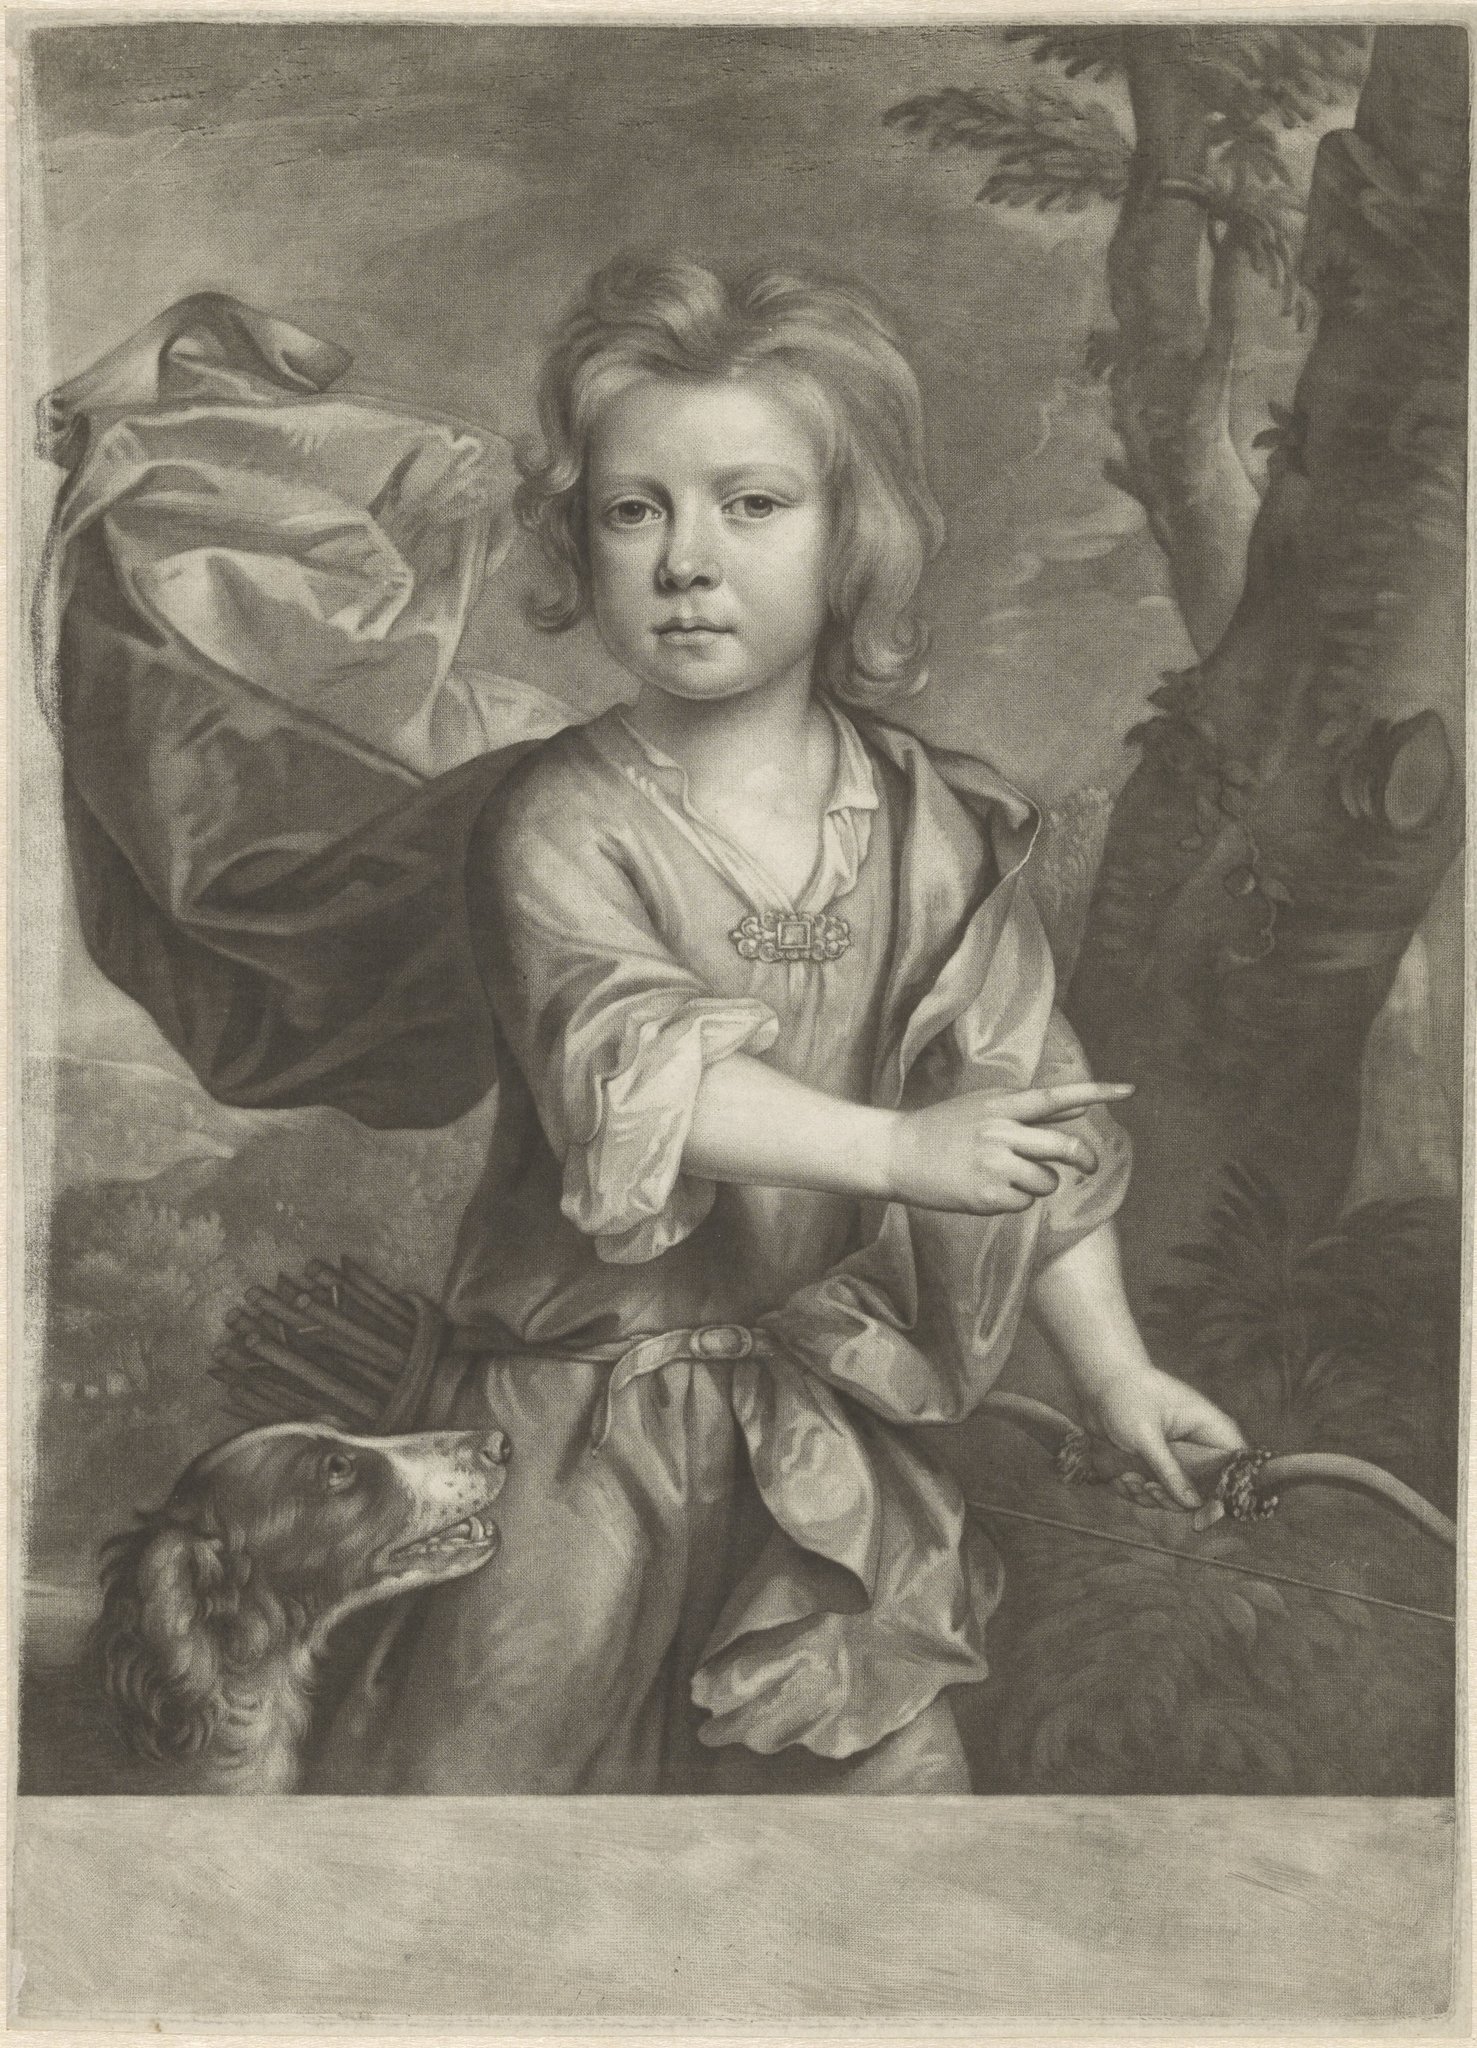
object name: print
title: Portret van een wijzende jongen met boog en pijlenkoker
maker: Anonymous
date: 1650-1800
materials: paper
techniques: mezzotint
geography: netherlands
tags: archer's weapons: bow and arrow, boy (child between toddler and youth), dog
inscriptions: collector's mark: Lugt 240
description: Portret van een wijzende jongen met boog en pijlenkoker in een landschap. Naast hem een jachthond.